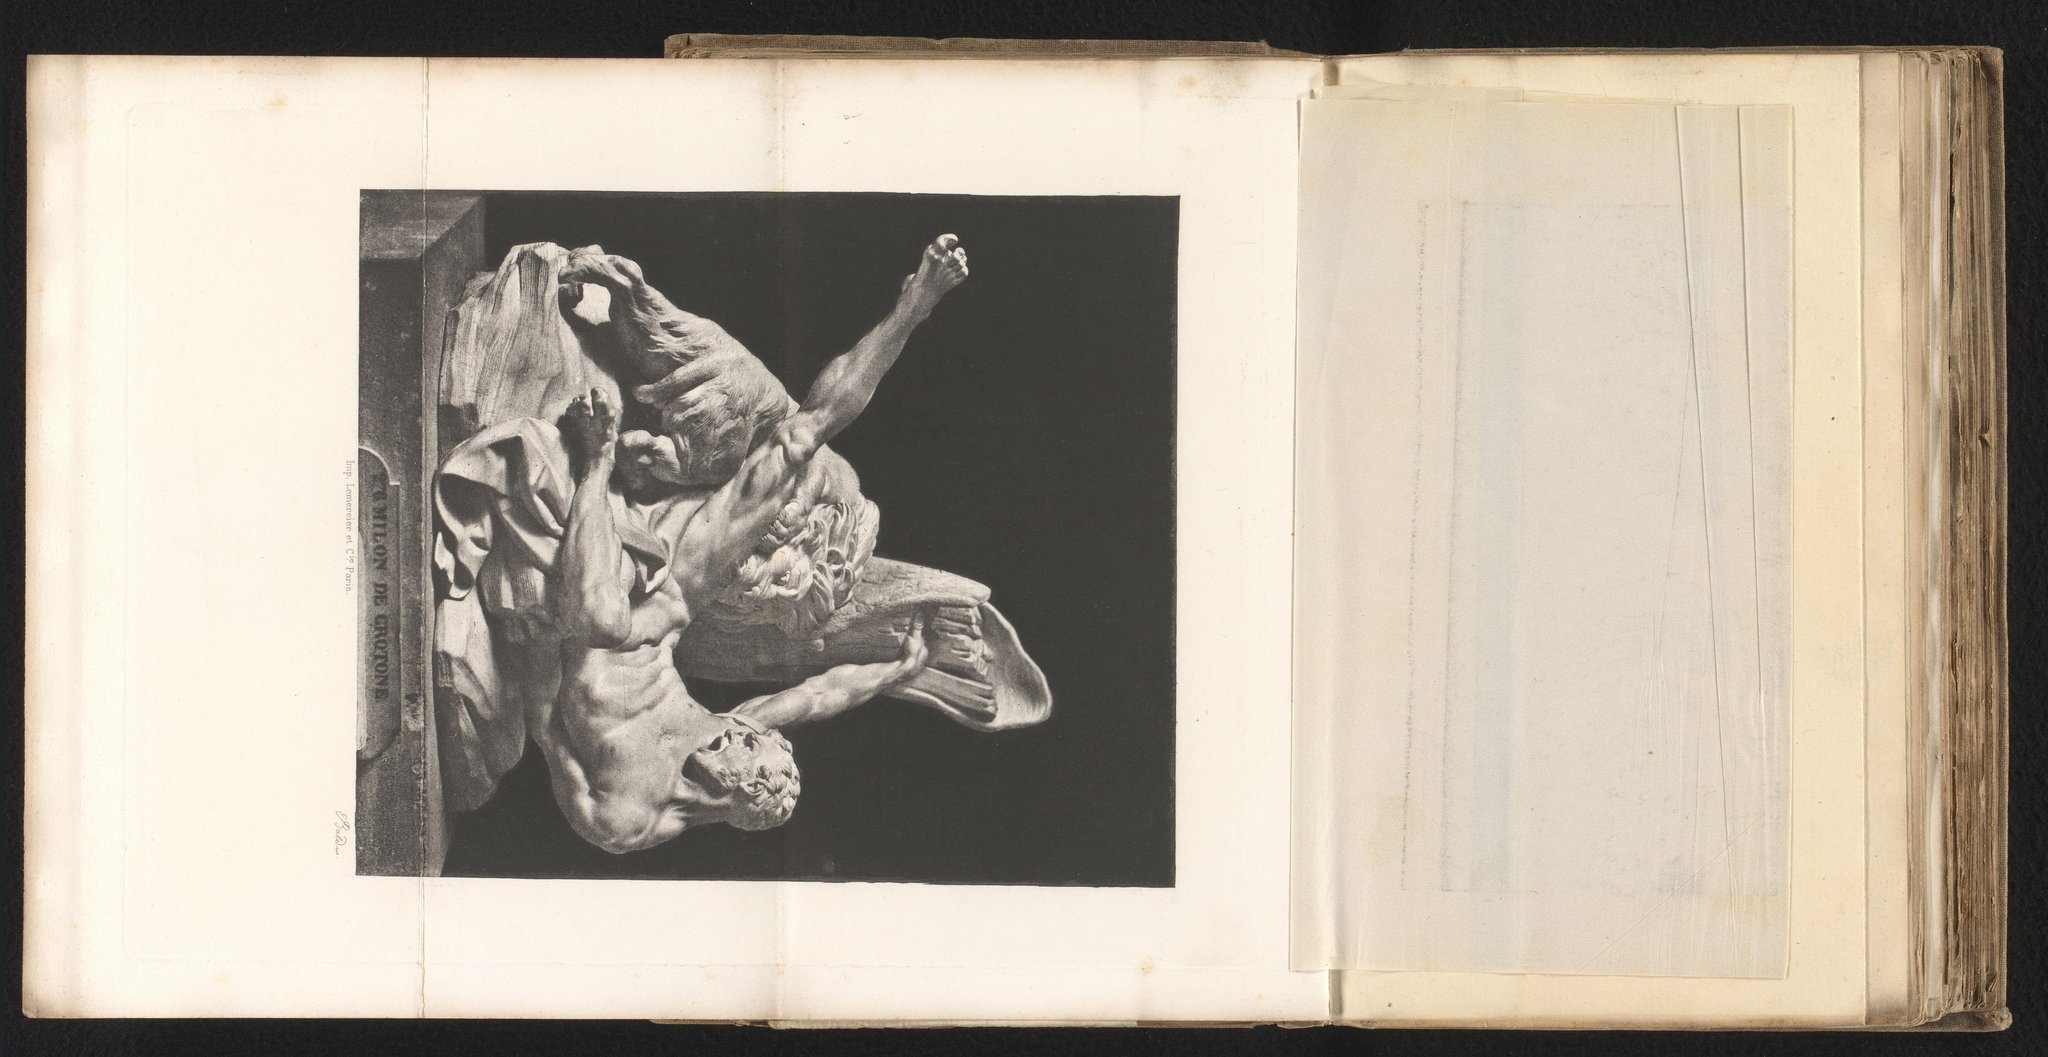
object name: photomechanical print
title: Sculptuur van Milo van Croton gebeten door een leeuw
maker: édouard denis baldus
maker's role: fotograaf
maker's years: 1813-1889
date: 1865-1870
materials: paper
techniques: photoaquatint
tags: piece of sculpture, reproduction of a piece of sculpture, (story of) milon of croton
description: Prent op achtste ongenummerde pagina na pagina 202.